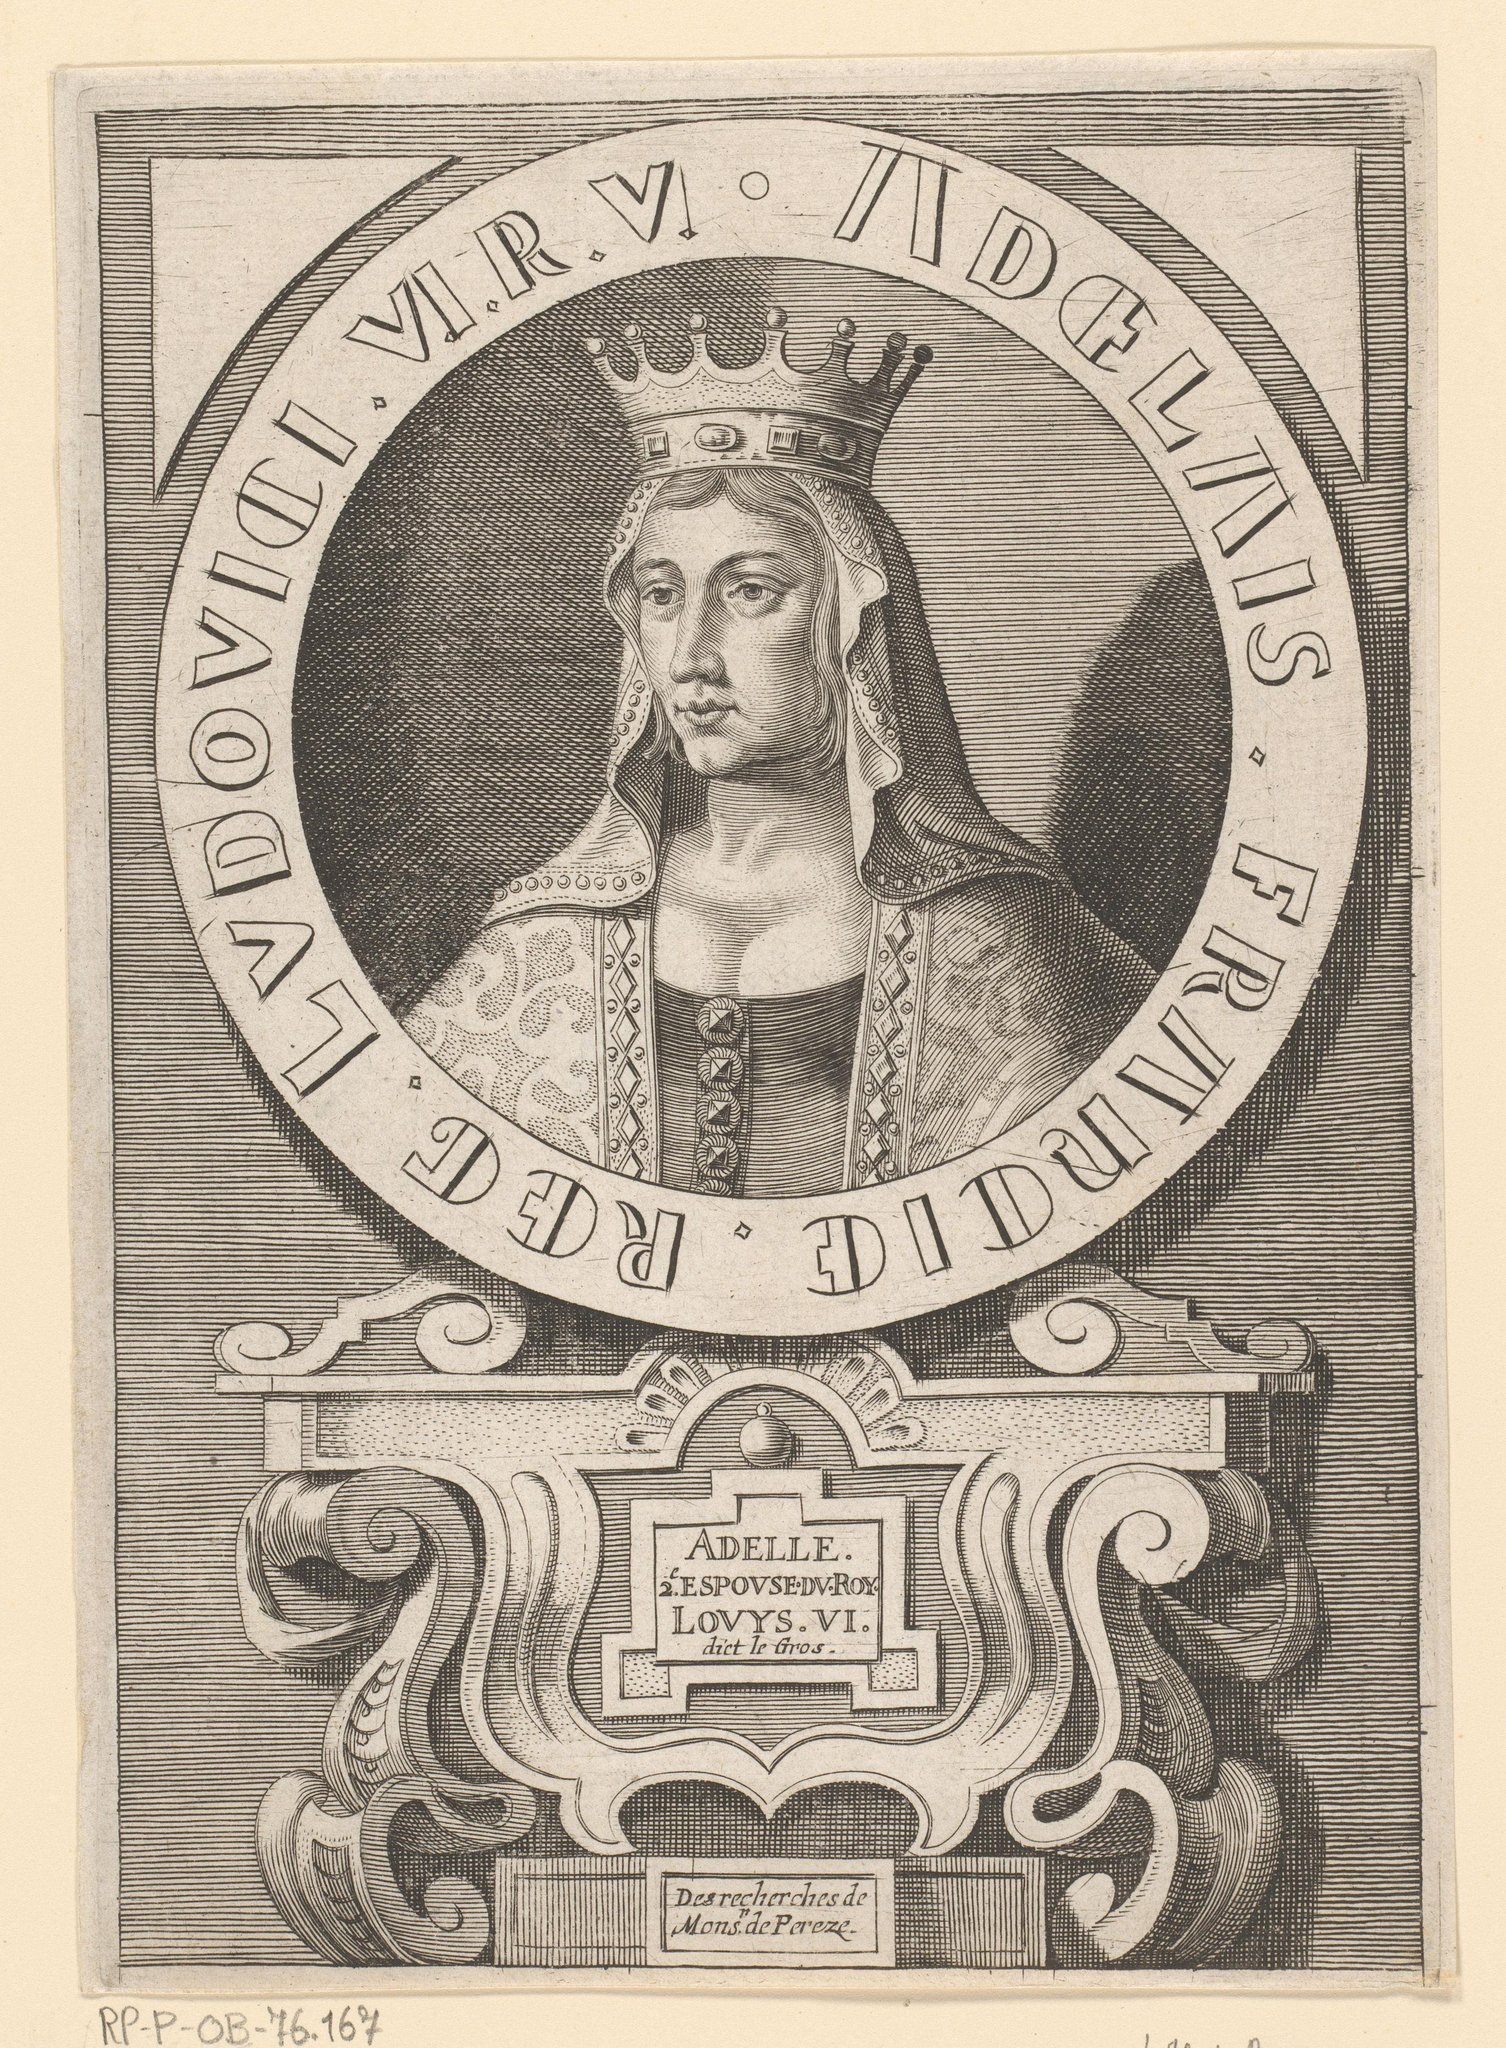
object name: print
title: Adelle ae. espouse du roy Louys VI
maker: jacques de bie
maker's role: print maker, publisher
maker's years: 1581-1647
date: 1634-1685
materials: paper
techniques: engraving, letterpress printing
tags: historical persons, queen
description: Prent waarschijnlijk voor het eerst verschenen in: Bie, Jacques de. Les vrais portraits des rois de France (...). Parijs: Jacques de Bie en Pierre Rocolet, 1634. Prent ook gebruikt in latere publicaties, in ieder geval tot in 1685.